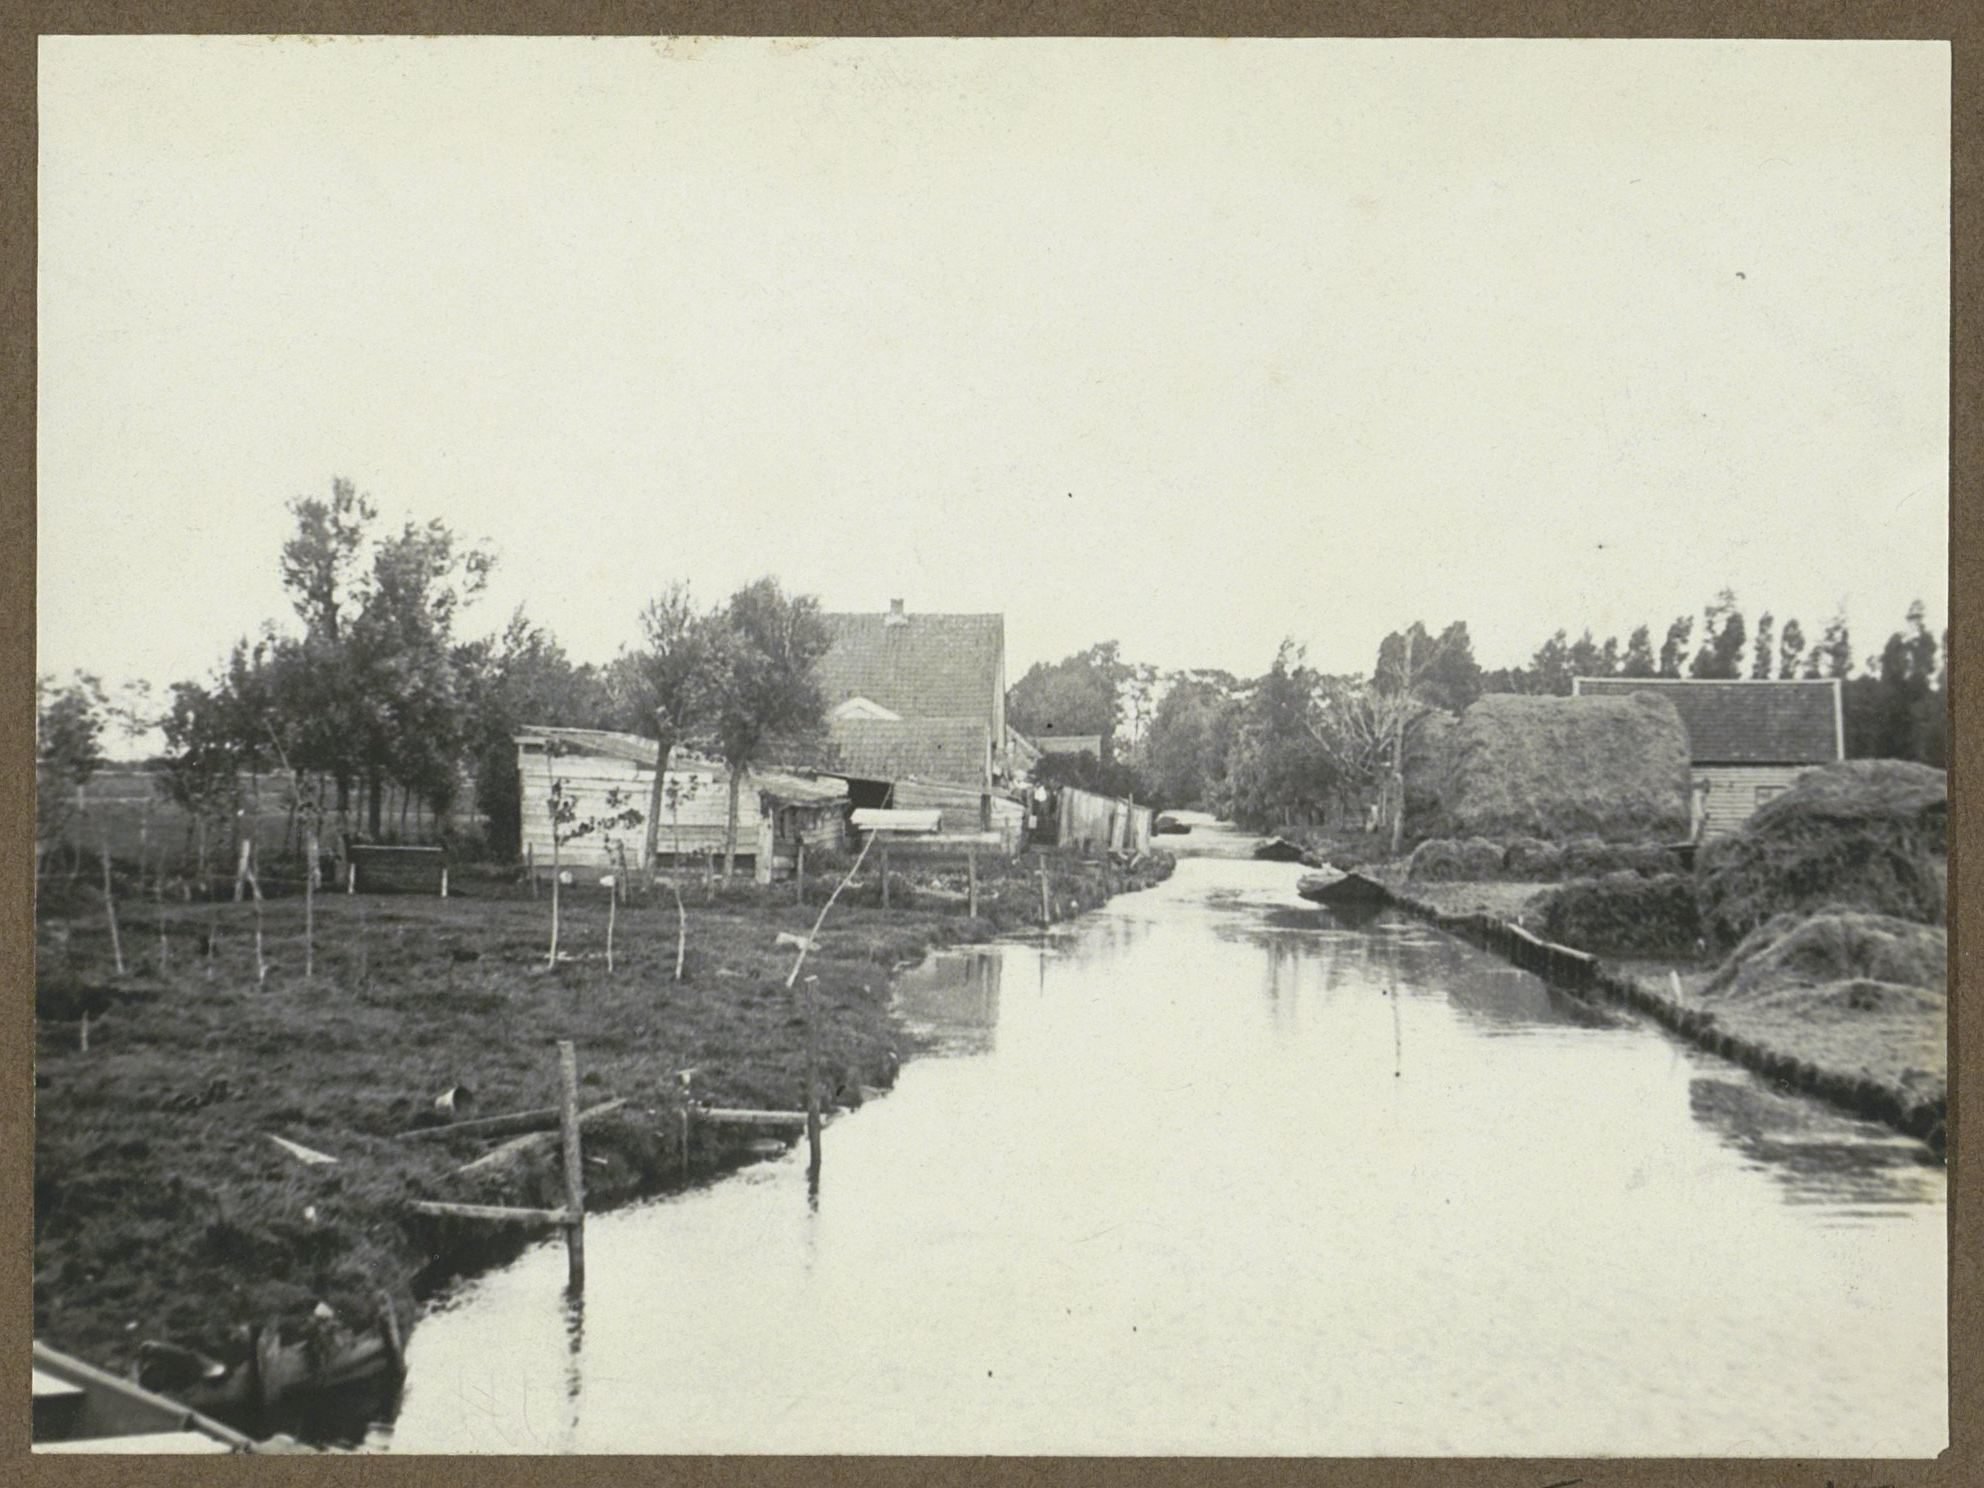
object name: photograph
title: Huizen aan het het Jaagpad bij Amsterdam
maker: Anonymous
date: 1910-1930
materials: paper, photographic support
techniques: gelatin silver print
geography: amsterdam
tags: river, rural housing, e.g. country-house, villa, cottage, amsterdam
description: Onderdeel van Album met foto's van Amsterdam en omgeving.